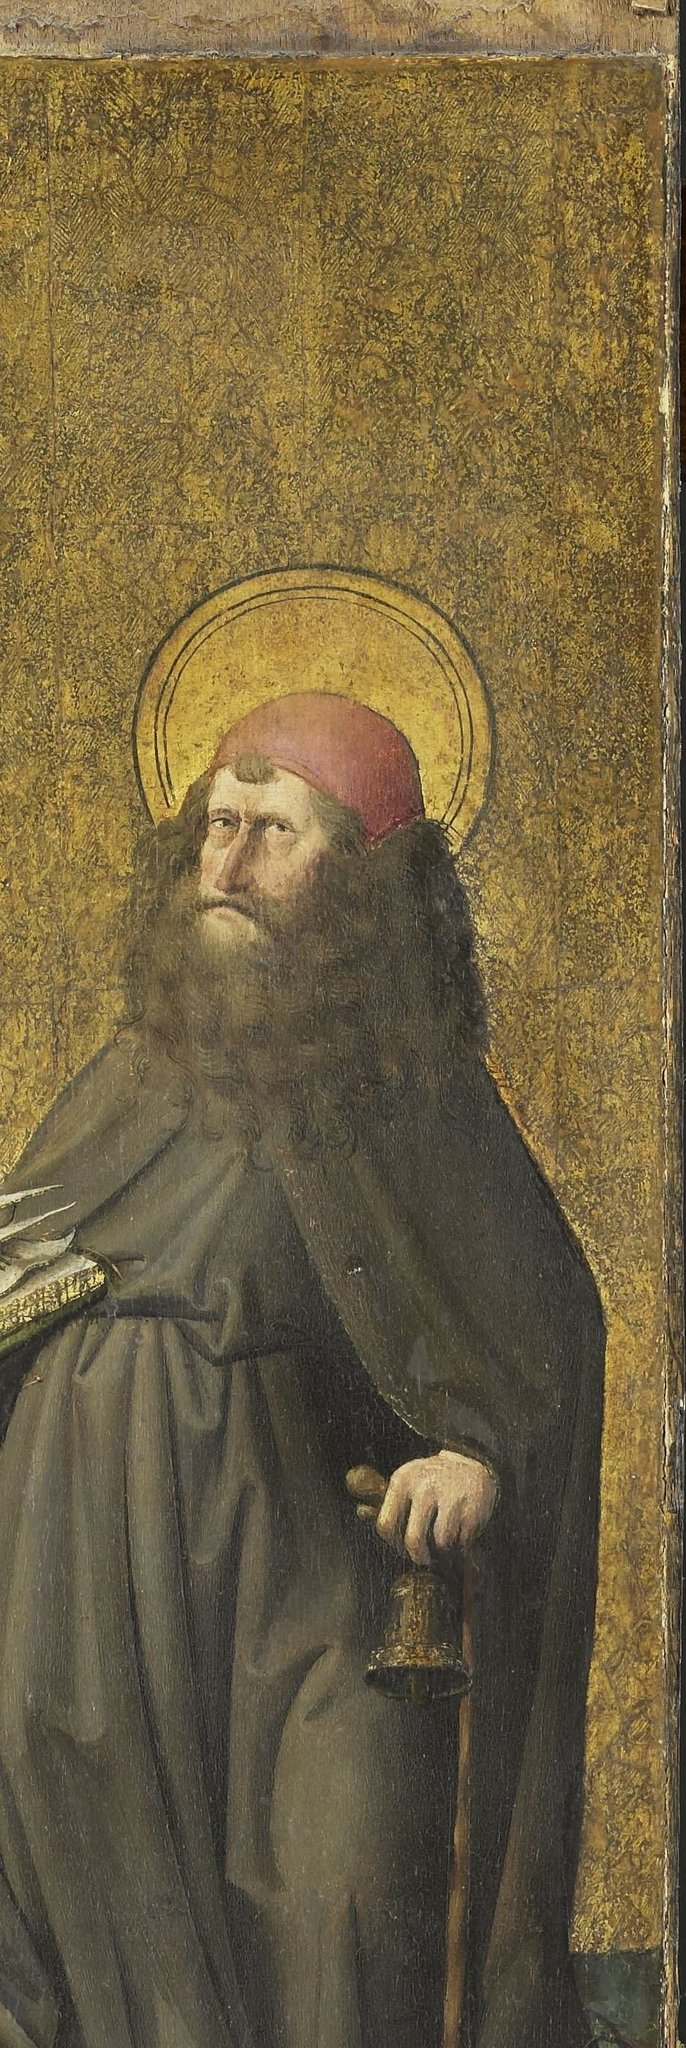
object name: painting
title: Saint Antony Abbot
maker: meester e.s.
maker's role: print maker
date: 1460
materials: oil, panel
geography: upper rhine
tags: the hermit antony abbot (antonius abbas) of egypt, also called the great; possible attributes: bell, book, t-shaped staff, flames, pig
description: De heilige Antonius abt, staande ten voeten uit, bij zijn voeten een zwijntje. Rechter zijpaneel van een altaarstuk. Pendant van SK-A-3311.